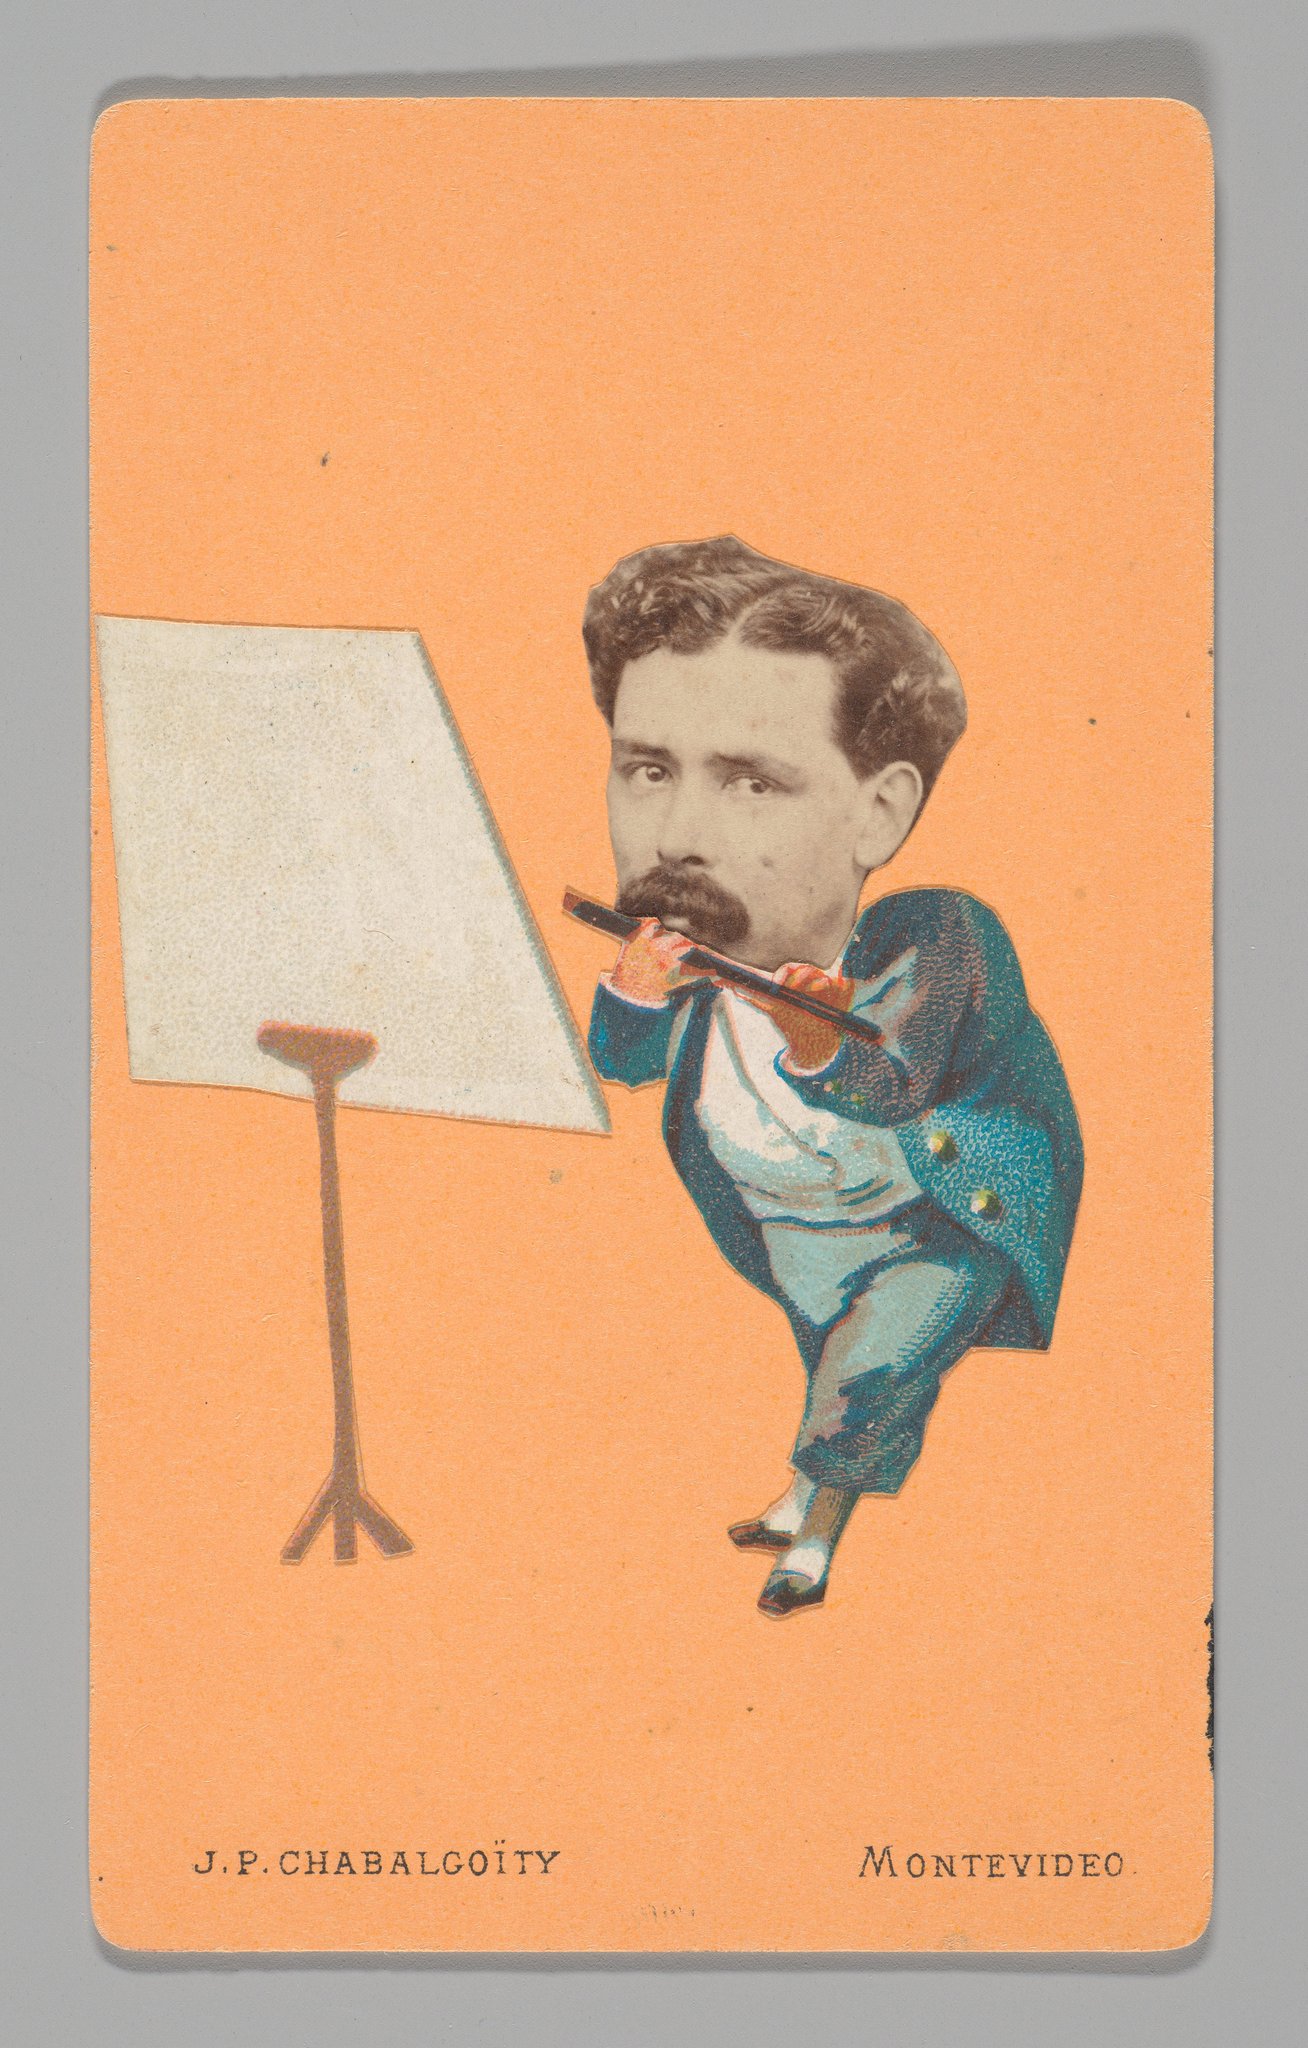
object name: carte de visite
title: [Photo Collage: Musician Playing Flute]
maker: juan pedro chabalgoity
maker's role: artist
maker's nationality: uruguayan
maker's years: 1848-1909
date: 1875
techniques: albumen silver print, lithograph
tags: men,flutes,musicians